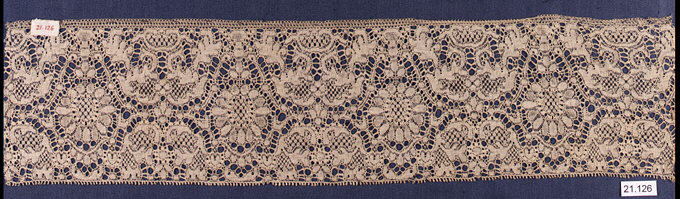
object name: strip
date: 1801-1900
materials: lace